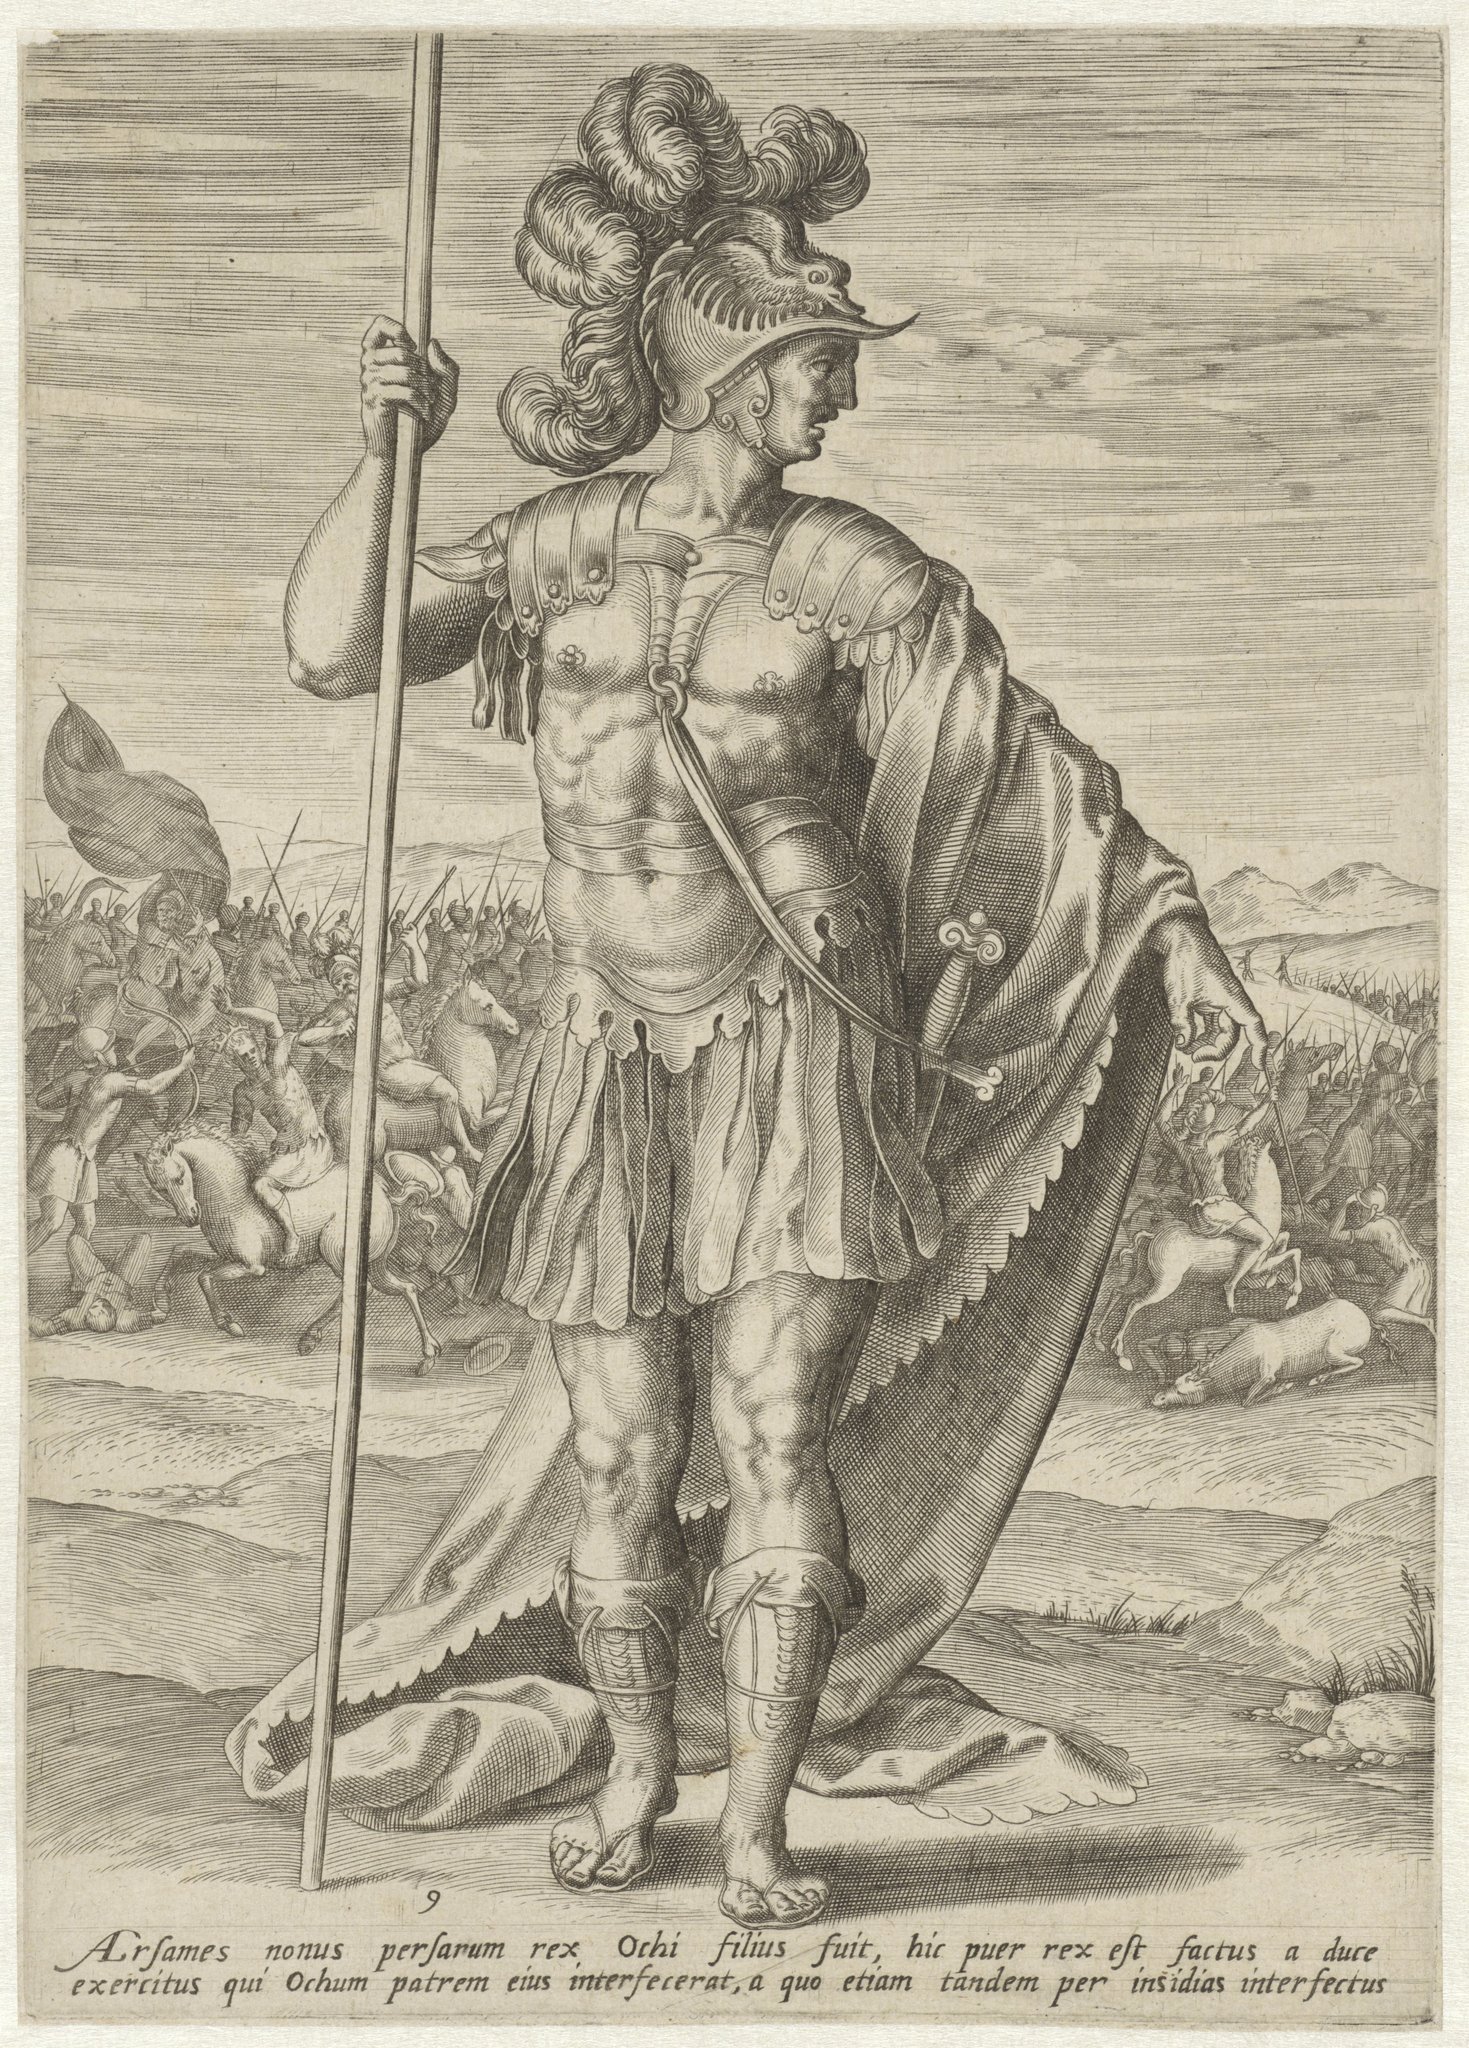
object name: print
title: Series Regum Persarum (...)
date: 1547-1585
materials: paper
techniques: engraving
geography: antwerp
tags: battle, male persons from classical history, ruler, sovereign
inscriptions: collector's mark: Lugt 2228, collector's mark: Lugt 2760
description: Koning Arsames van Perzië staande met lange staf of lans in zijn hand. Op de achtergrond een veldslag. Onder de voorstelling een drieregelige tekst in het Latijn.